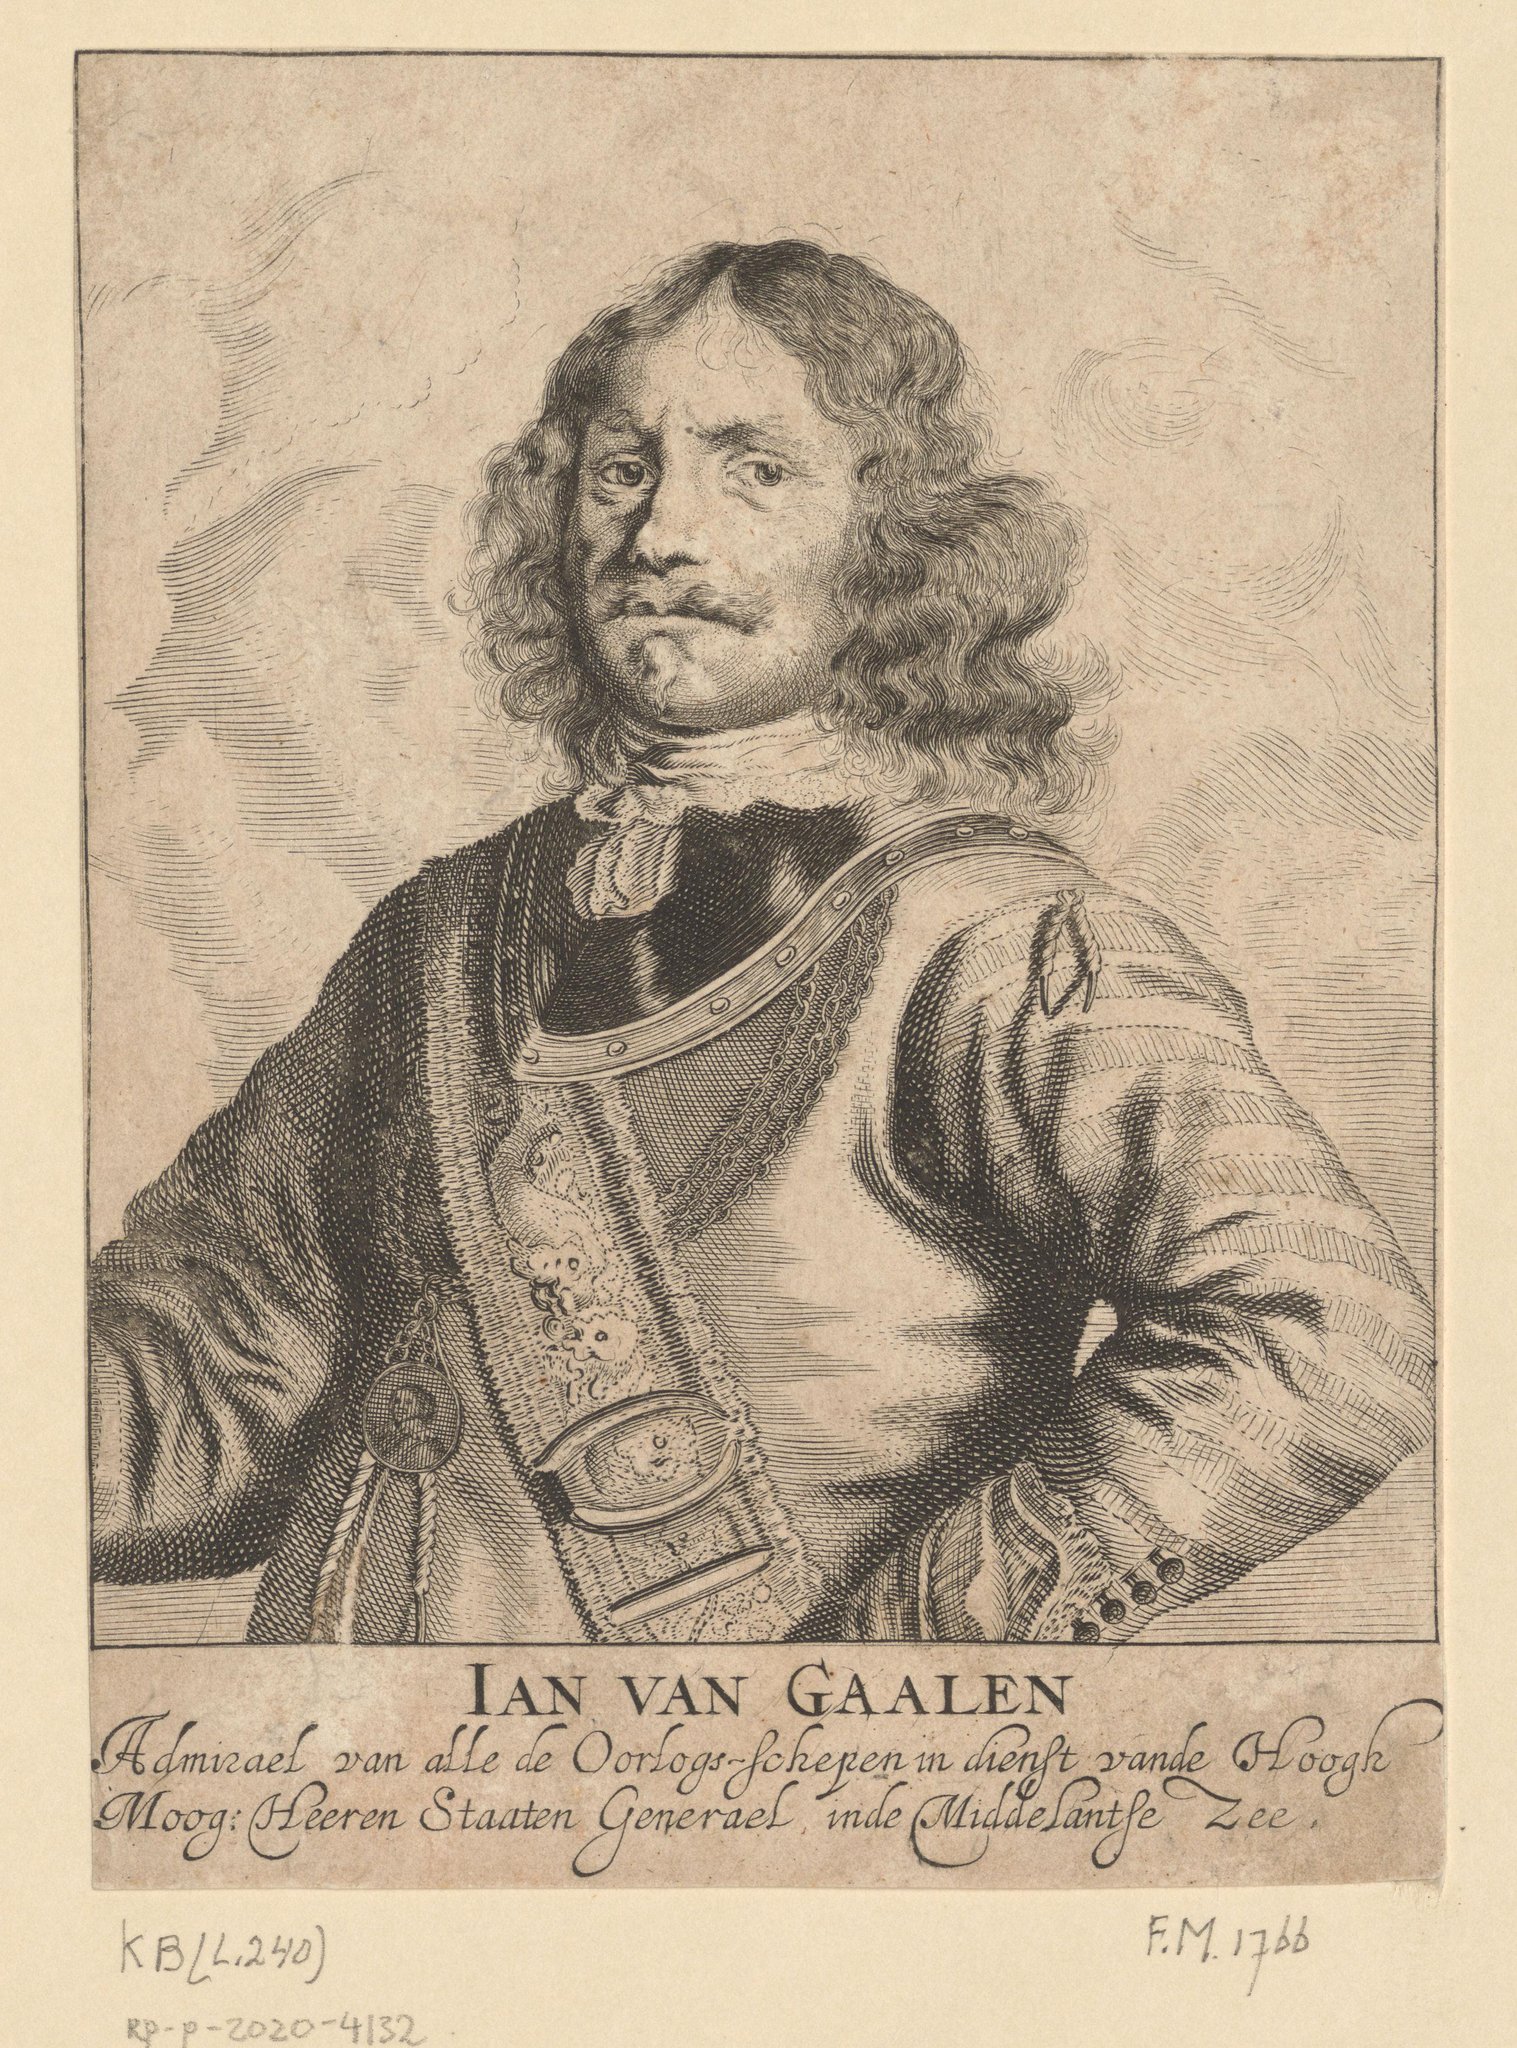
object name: print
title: Portret van Jan van Gaalen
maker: Anonymous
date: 1655-1704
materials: paper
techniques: engraving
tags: essen, commander-in-chief, general, marshal, historical persons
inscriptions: collector's mark: Lugt 240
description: Tekst in het Nederlands in de ondermarge.